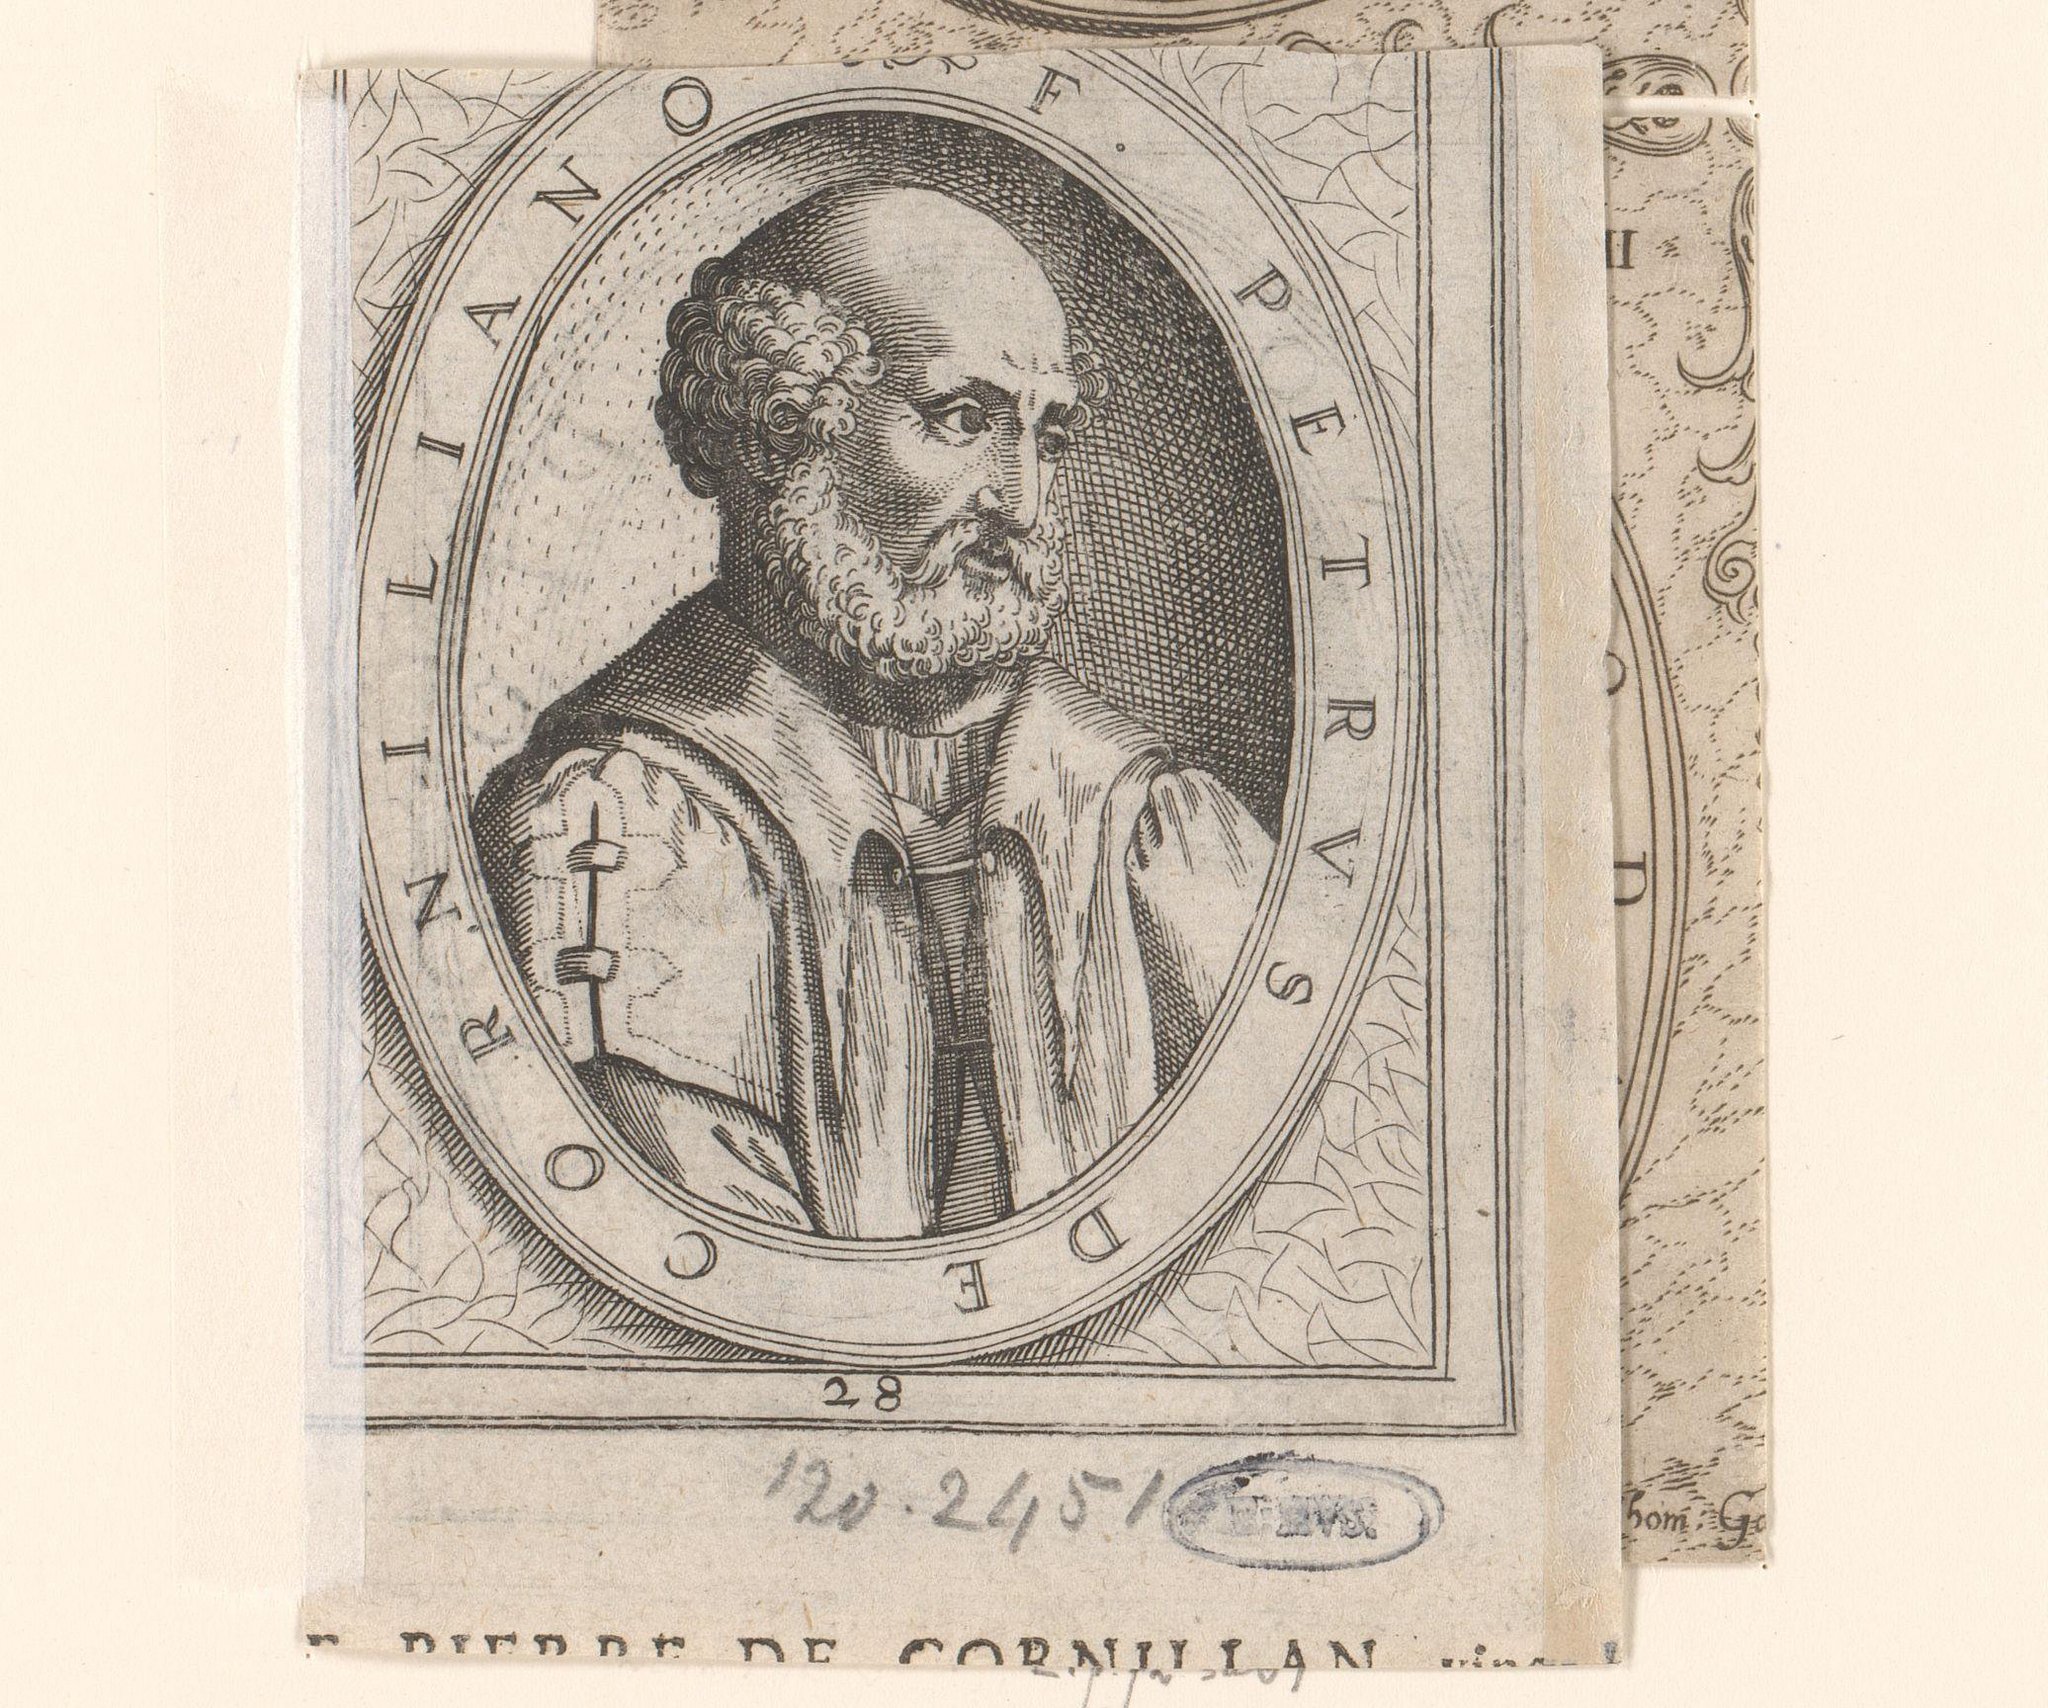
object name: print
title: Portret van Pierre de Corneillan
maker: Anonymous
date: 1643-1659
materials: paper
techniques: engraving, letterpress printing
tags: historical persons, military orders, e.g.: knights templars, knights of malta, teutonic knights ~ roman catholic church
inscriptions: collector's mark: Lugt 2228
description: Prent mogelijk uit: Baudoin, Jean. Histoire des chevaliers de l'ordre de s. Jean de Hierusalem (...). Parijs: Jacques Dallin, 1643. Of uit: Baudoin, Jean. Histoire des chevaliers de l'ordre de s. Jean de Hierusalem (...). Parijs: Thomas Jolly, 1659.